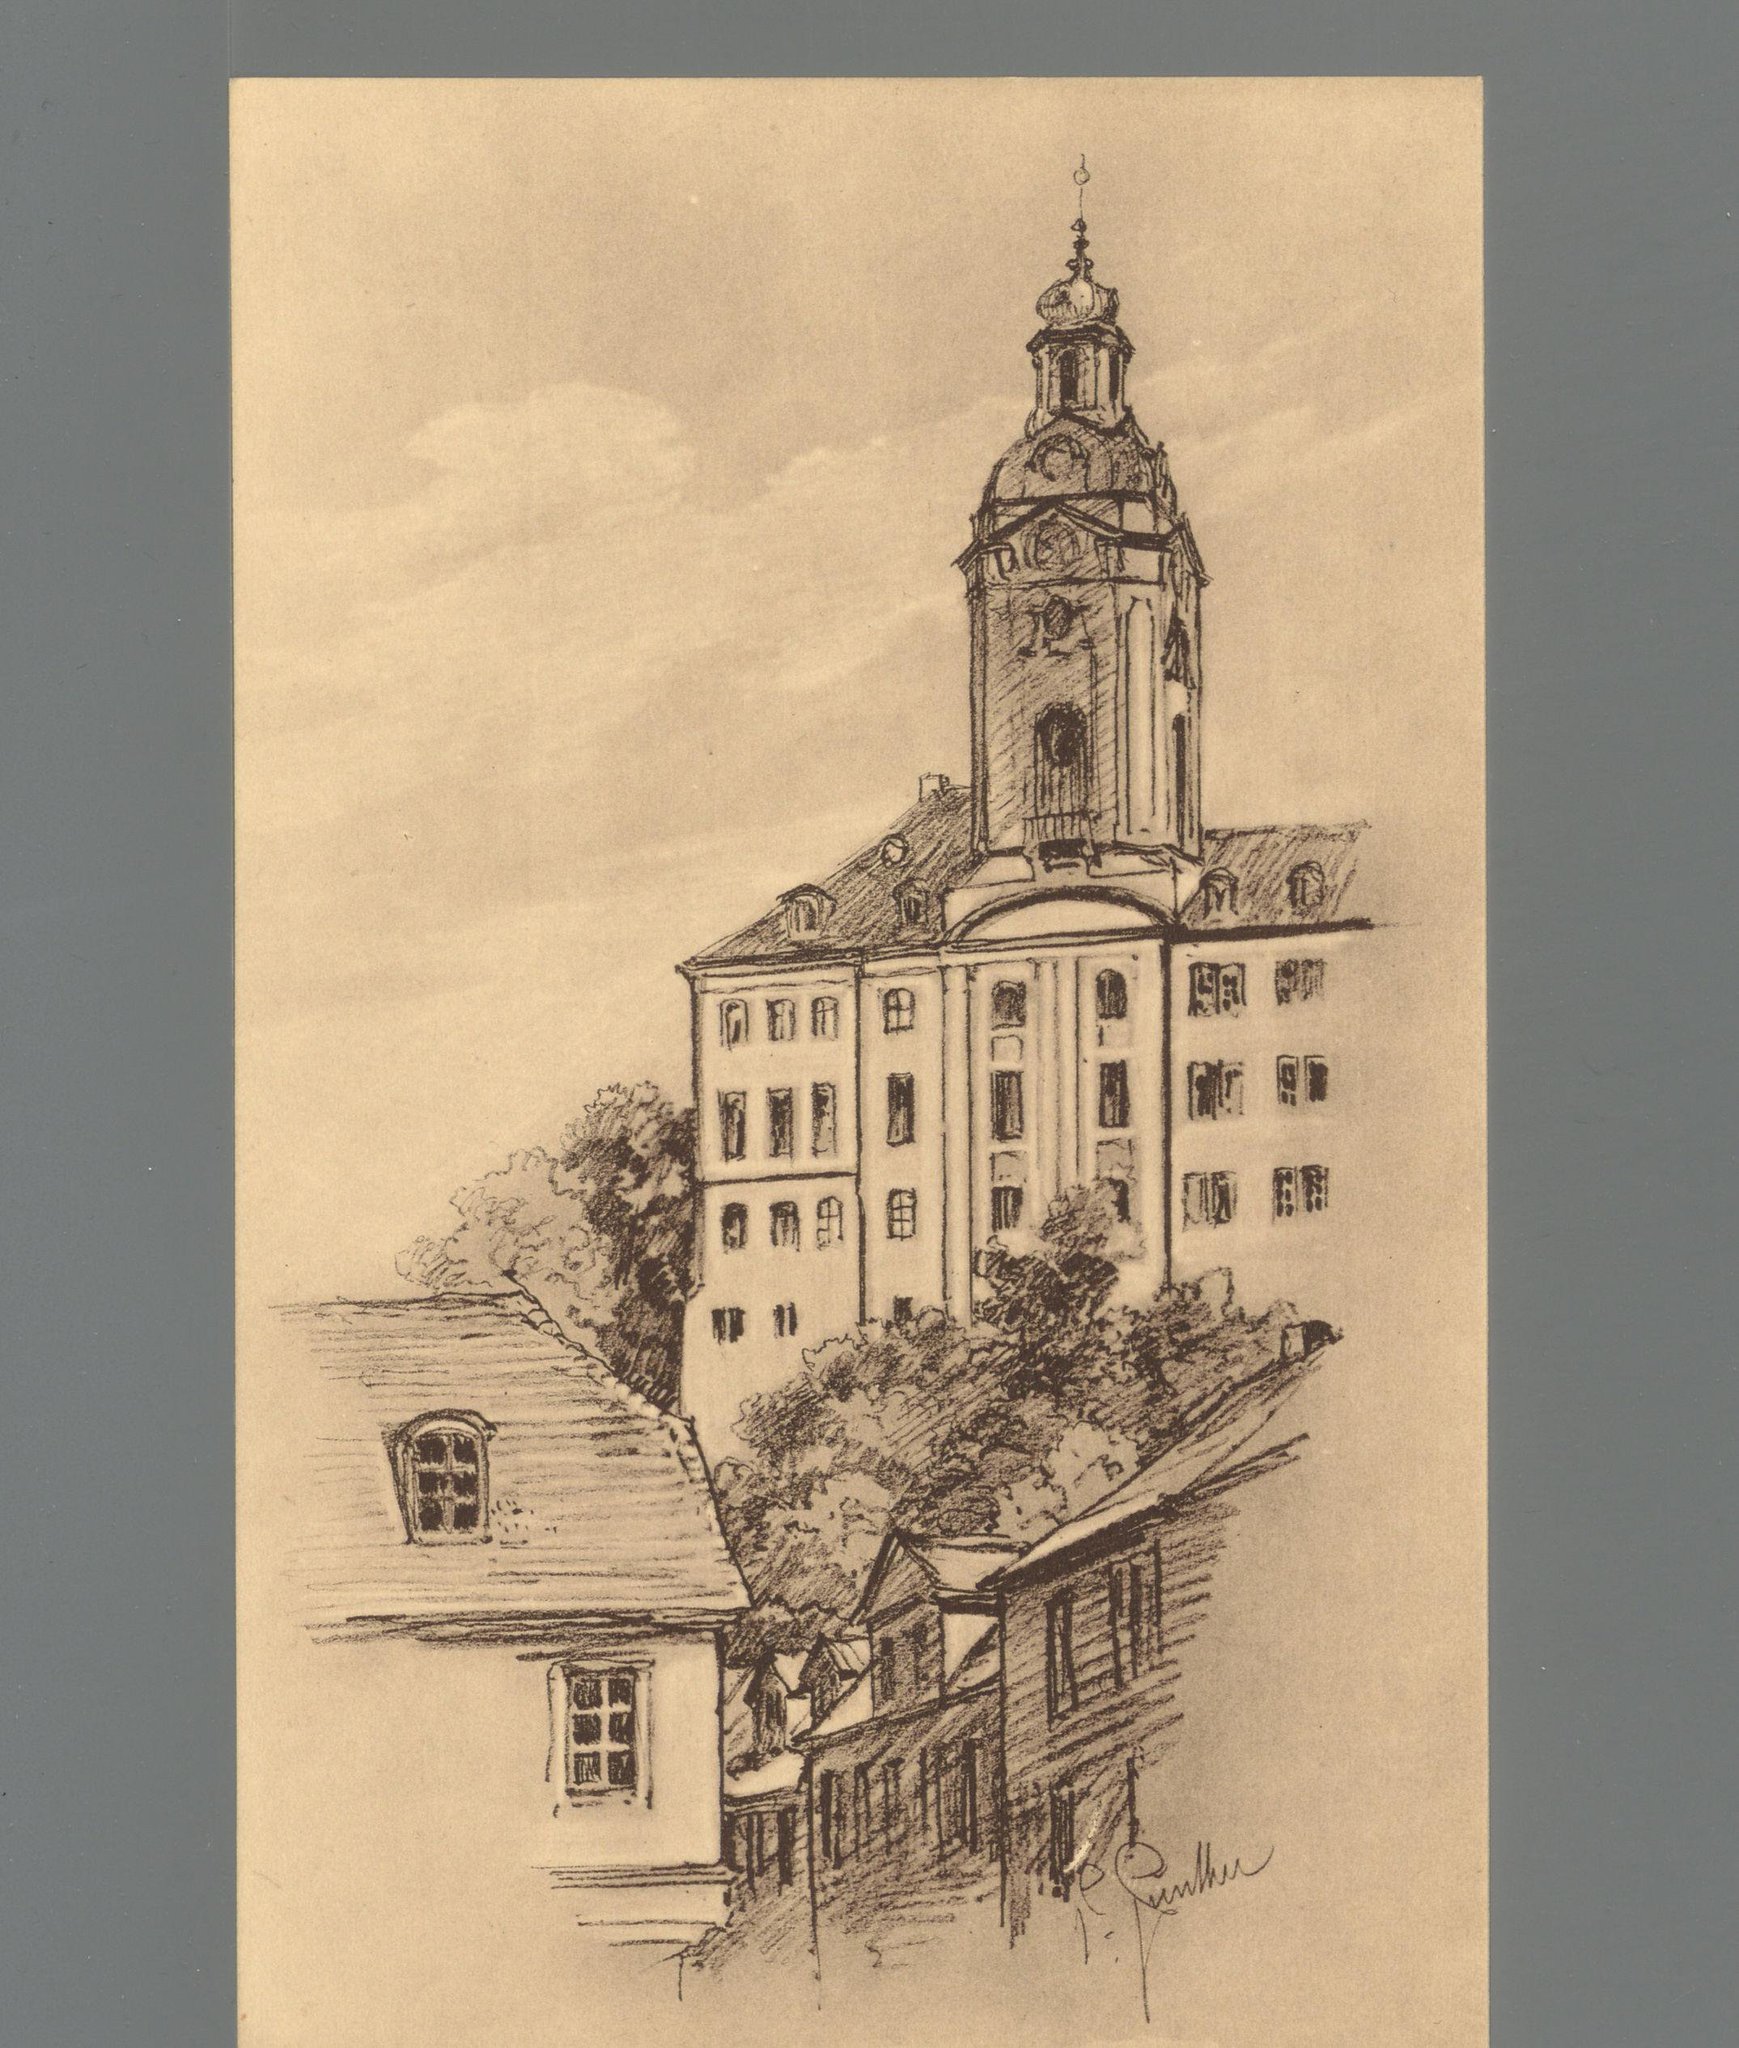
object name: reproduction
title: Rudolstadt. Schloss von der Vorwerksgasse aus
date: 1915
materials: cardboard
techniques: photograph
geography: rudolstadt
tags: castle